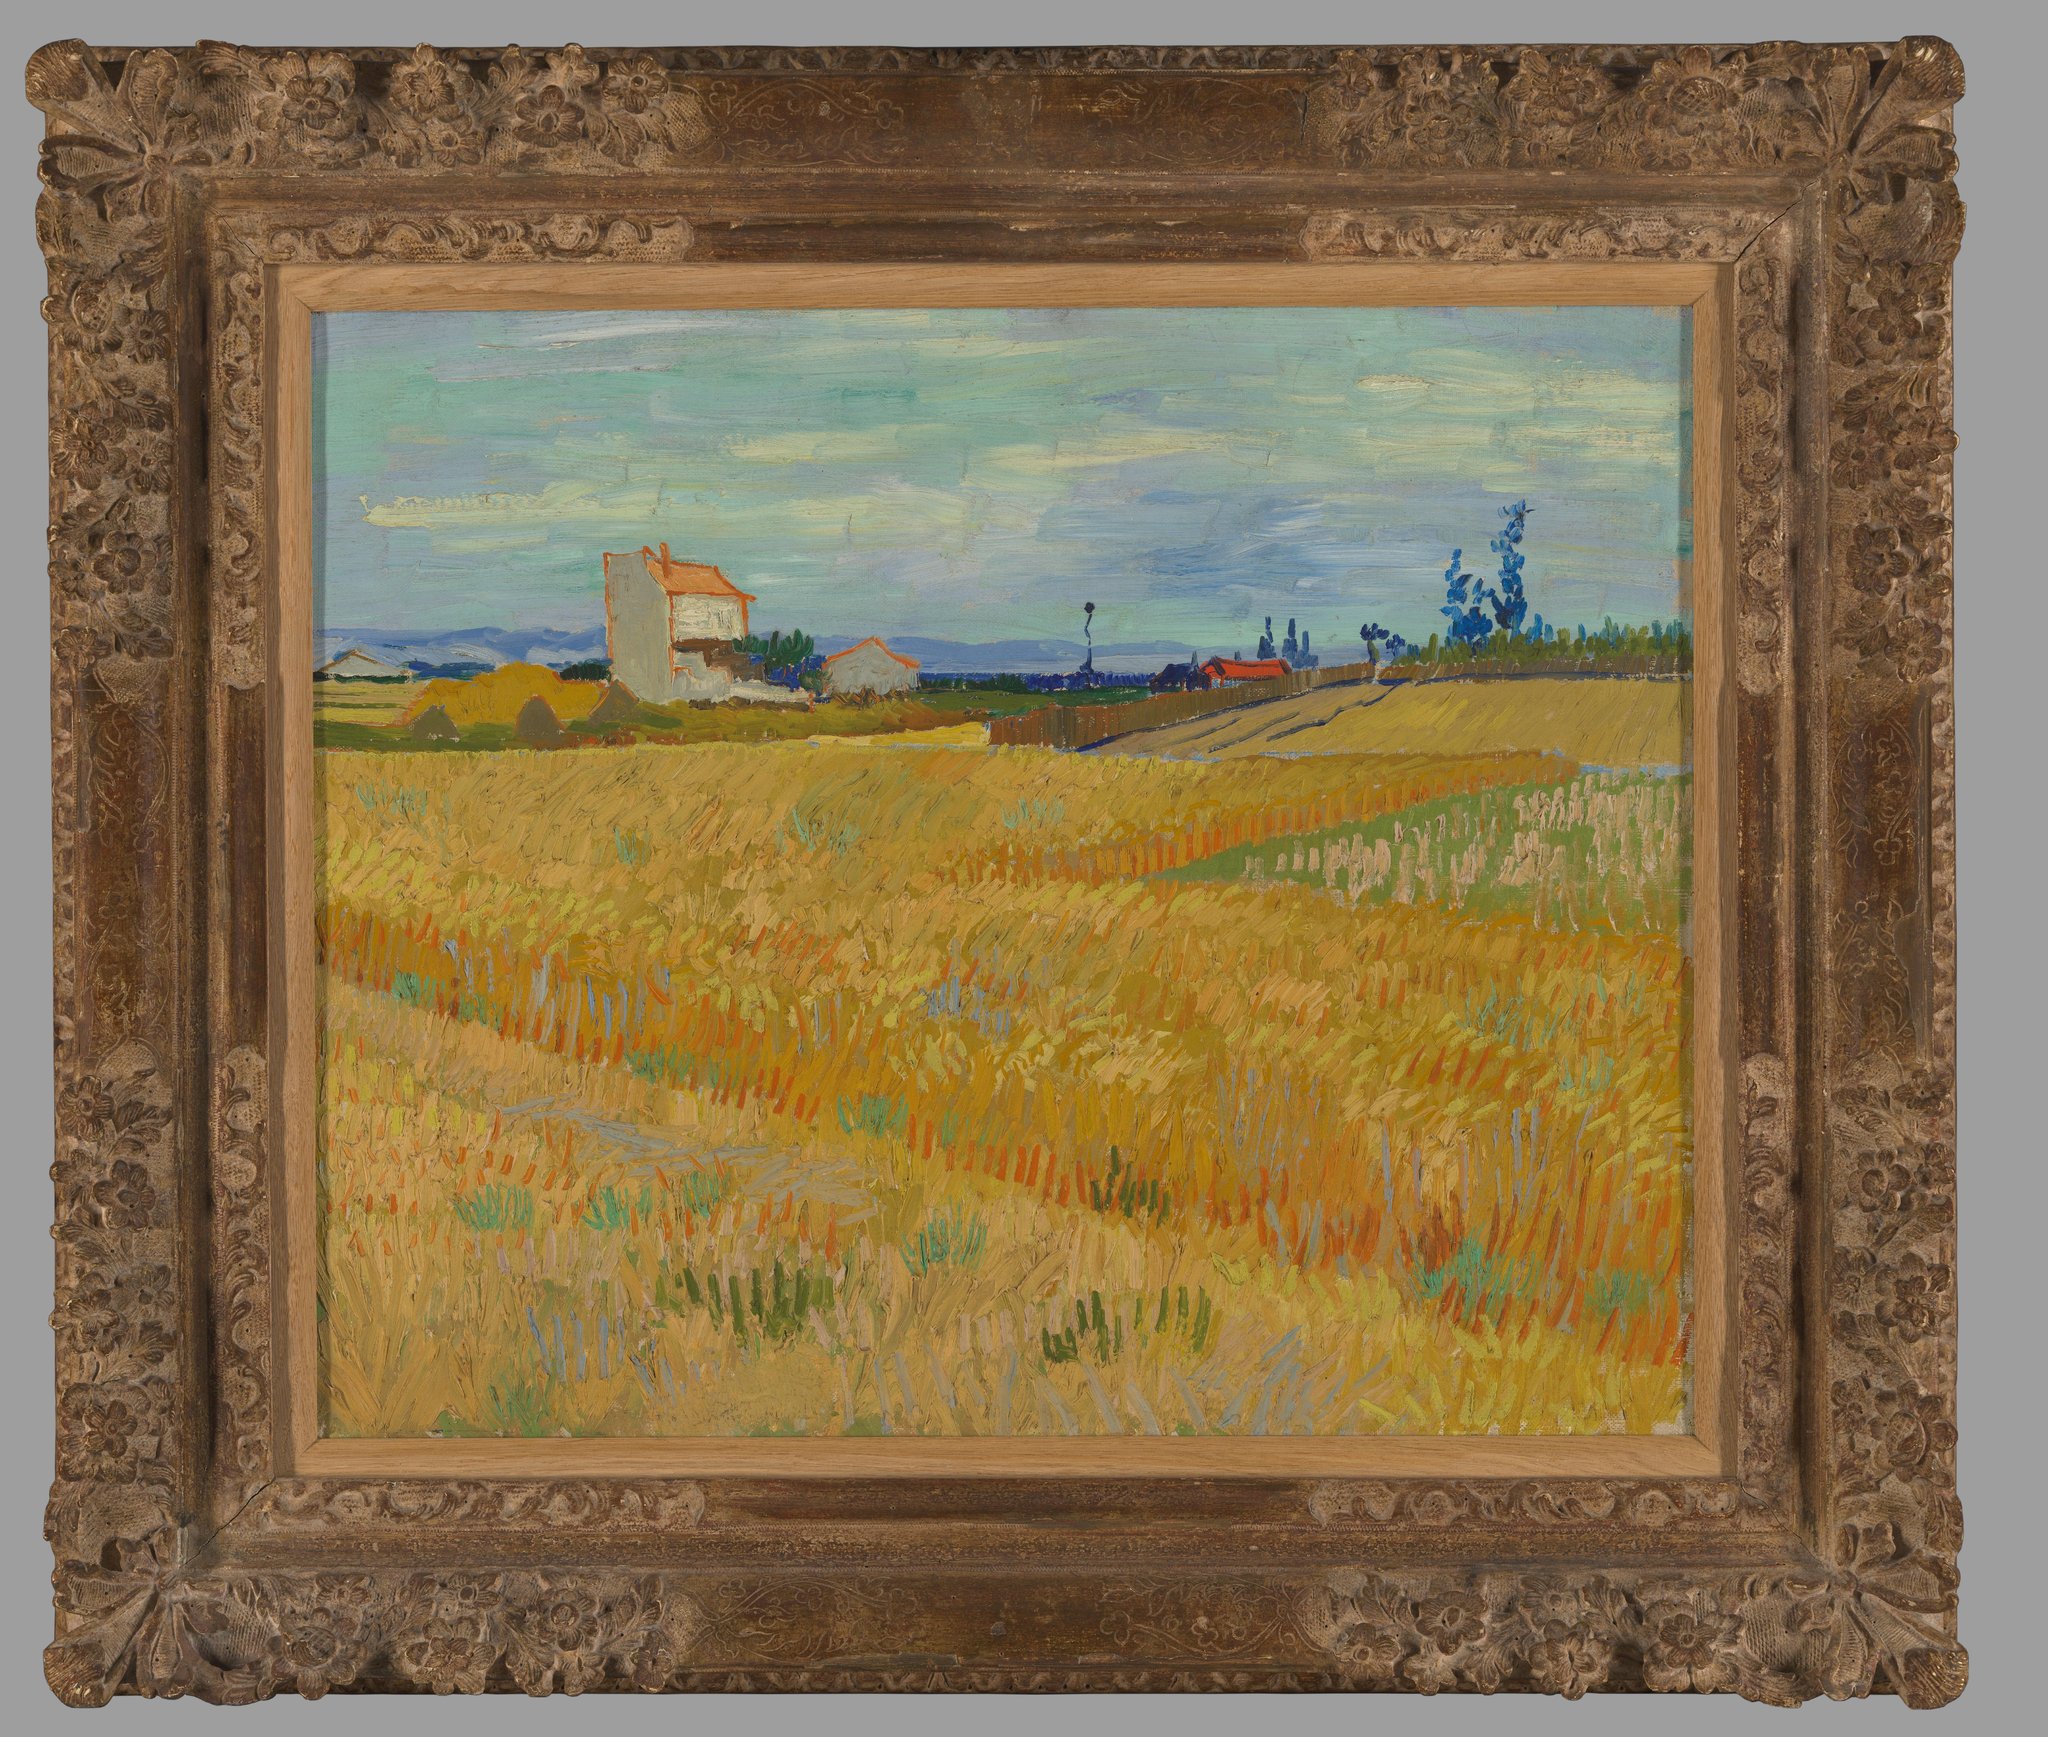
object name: frame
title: Vergulde lijst met gesneden ornamenten in Lodewijk XIII stijl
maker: Anonymous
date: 1800-1899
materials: gold leaf, wood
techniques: cutting, gilding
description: Vergulde lijst met gesneden ornamenten in Lodewijk XIII stijl. Op de middens van de lijstdelen bevindt zich een gearceerd en gestileerd bladmotief. De eikenhouten zool heeft een halfhout verbinding verstevigd met spijkertjes.